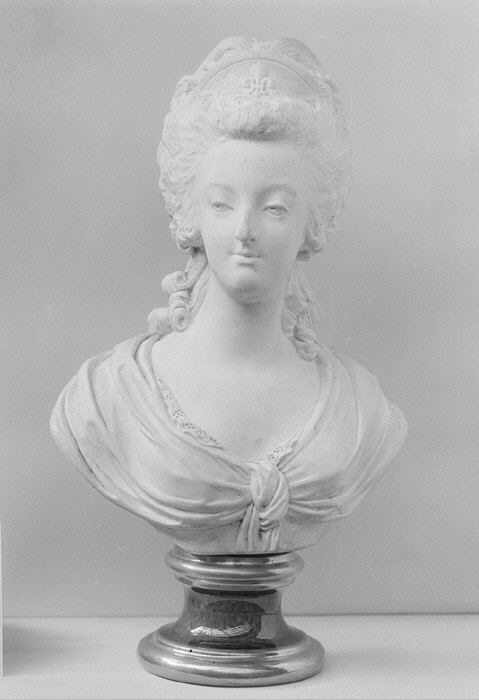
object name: bust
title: Marie Antoinette (1755–1793)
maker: sèvres manufactory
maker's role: manufactory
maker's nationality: french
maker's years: 1740-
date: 1821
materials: biscuit, hard paste porcelain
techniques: glazing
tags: queens,portraits